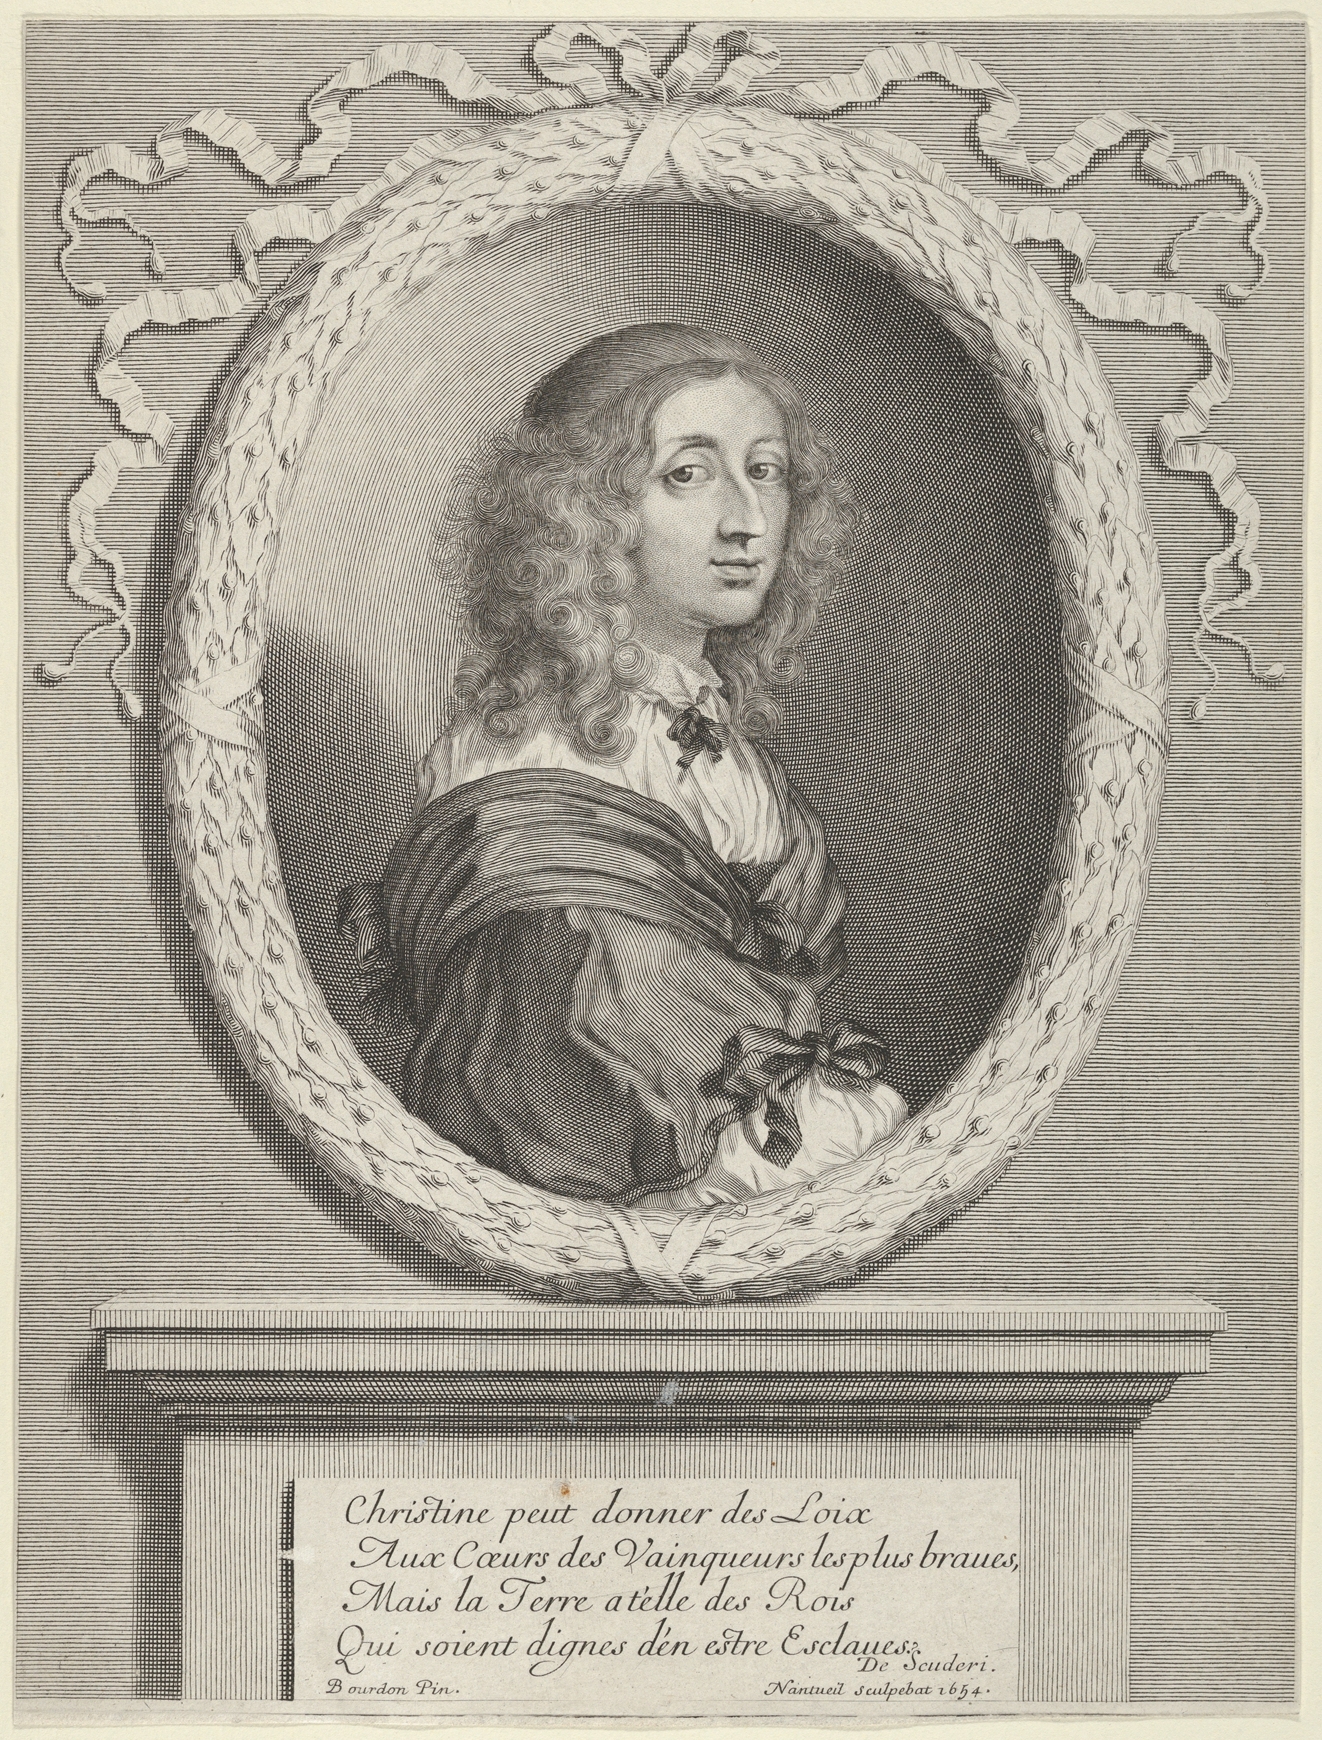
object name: print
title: Christine, reine de Suède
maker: robert nanteuil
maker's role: artist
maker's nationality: french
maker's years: 1623-1678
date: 1654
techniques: engraving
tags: portraits,women